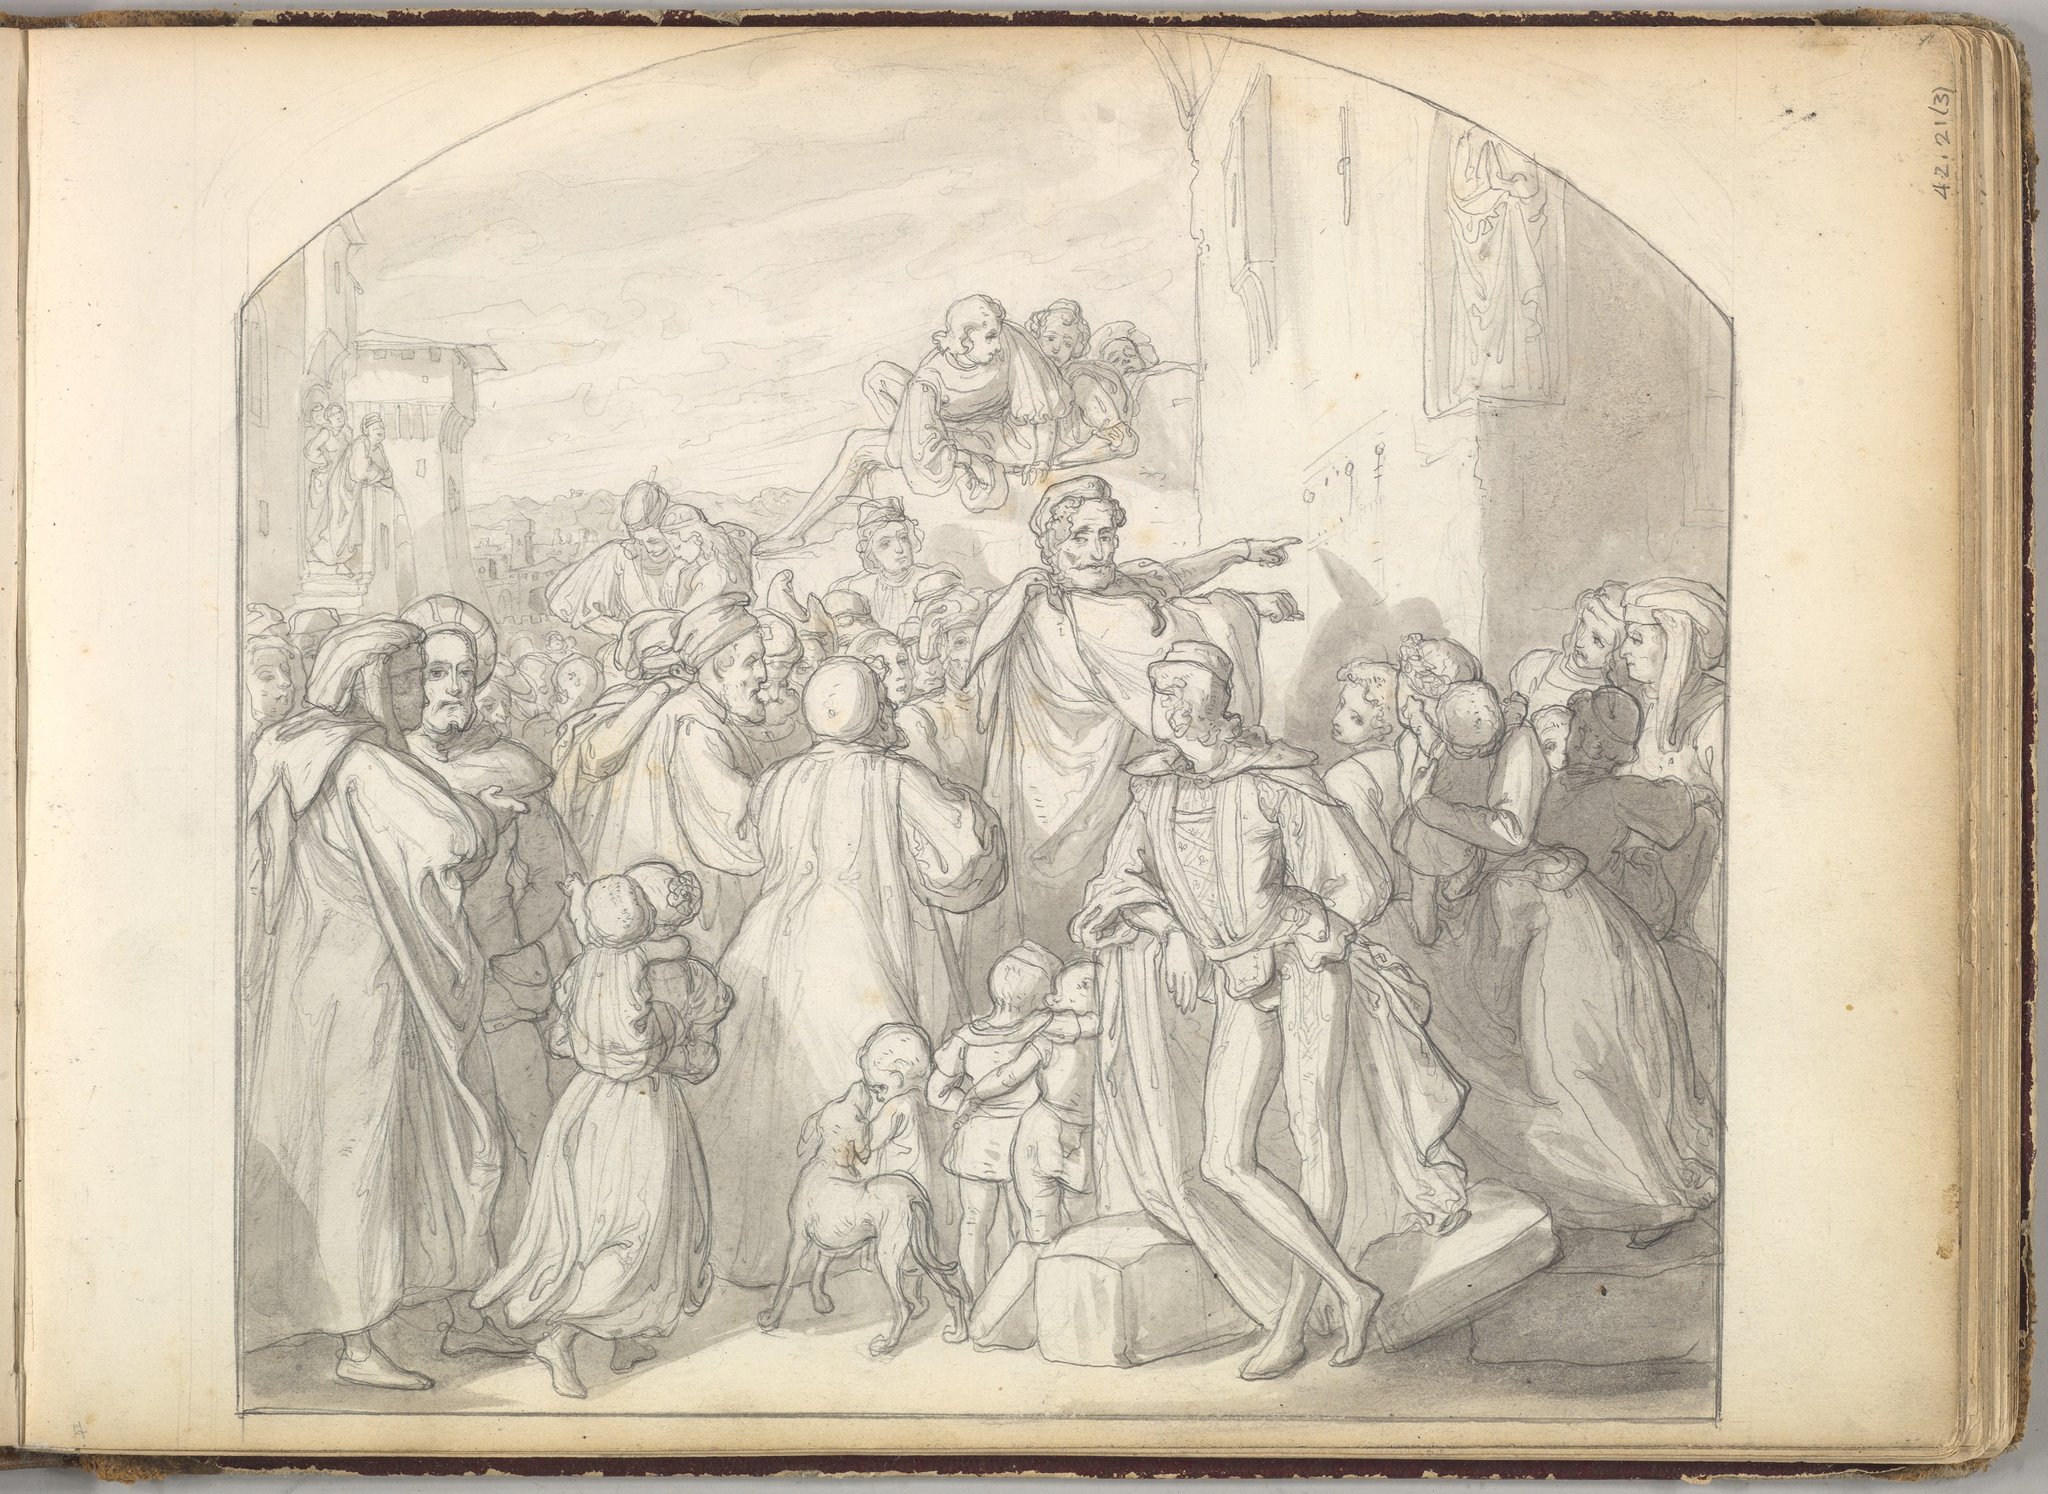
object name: drawing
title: An Artist Drawing on Wall of a Church Watched by a Crowd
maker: frederic, lord leighton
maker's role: artist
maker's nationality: british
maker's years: 1830-1896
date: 1849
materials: graphite, ink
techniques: brush, wash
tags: drawing,churches,men,crowd,artists